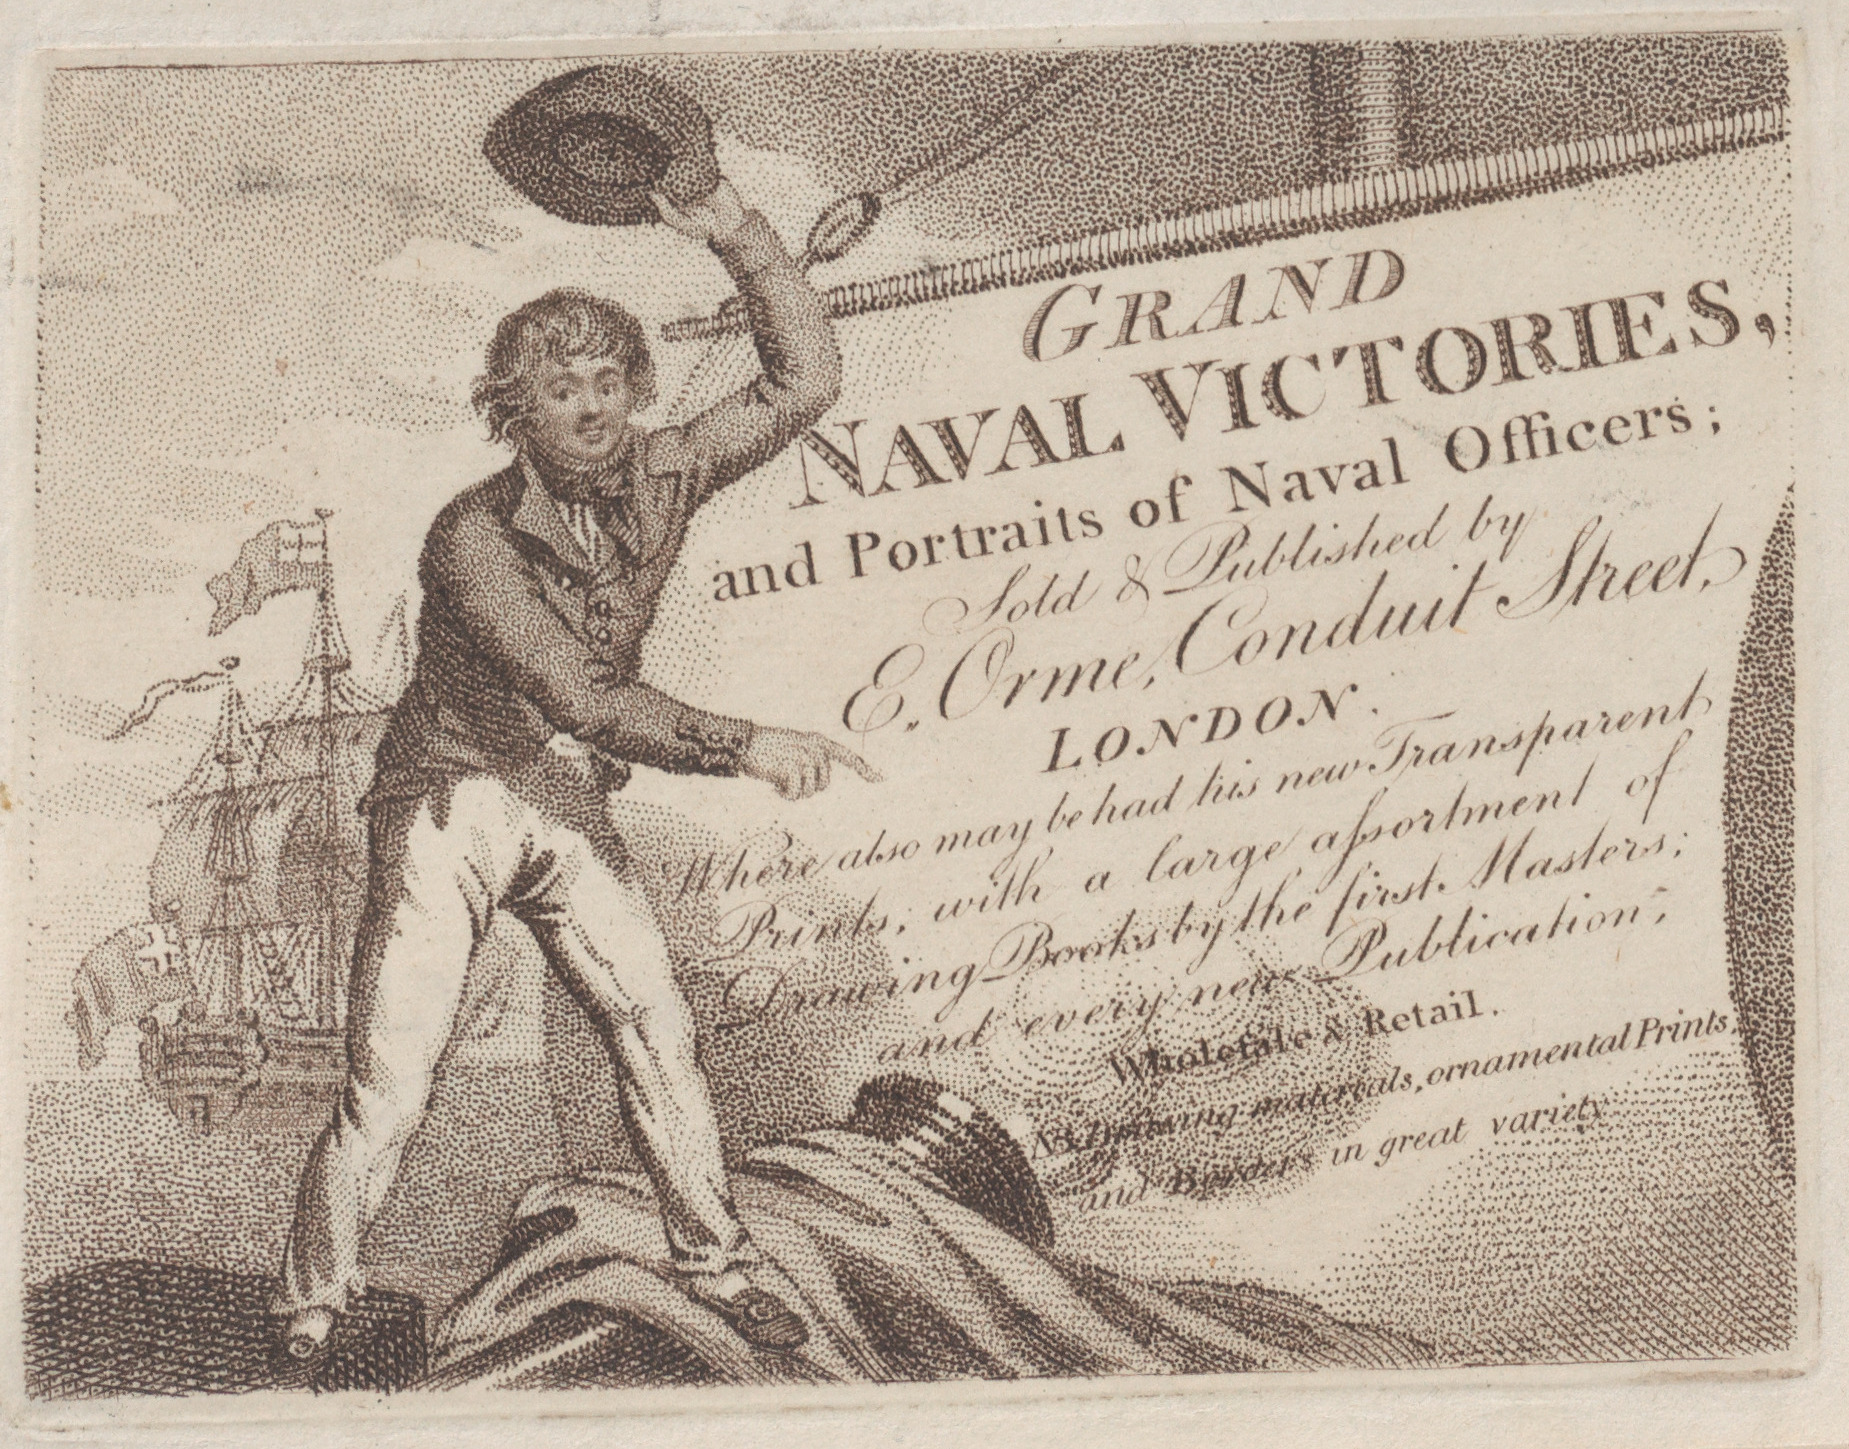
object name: print, trade card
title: Trade Card for E. Orme, Printseller and Publisher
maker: anonymous, british, late 18th–early 19th century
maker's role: artist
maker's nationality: british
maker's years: 1771-1835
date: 1801-1833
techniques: etching